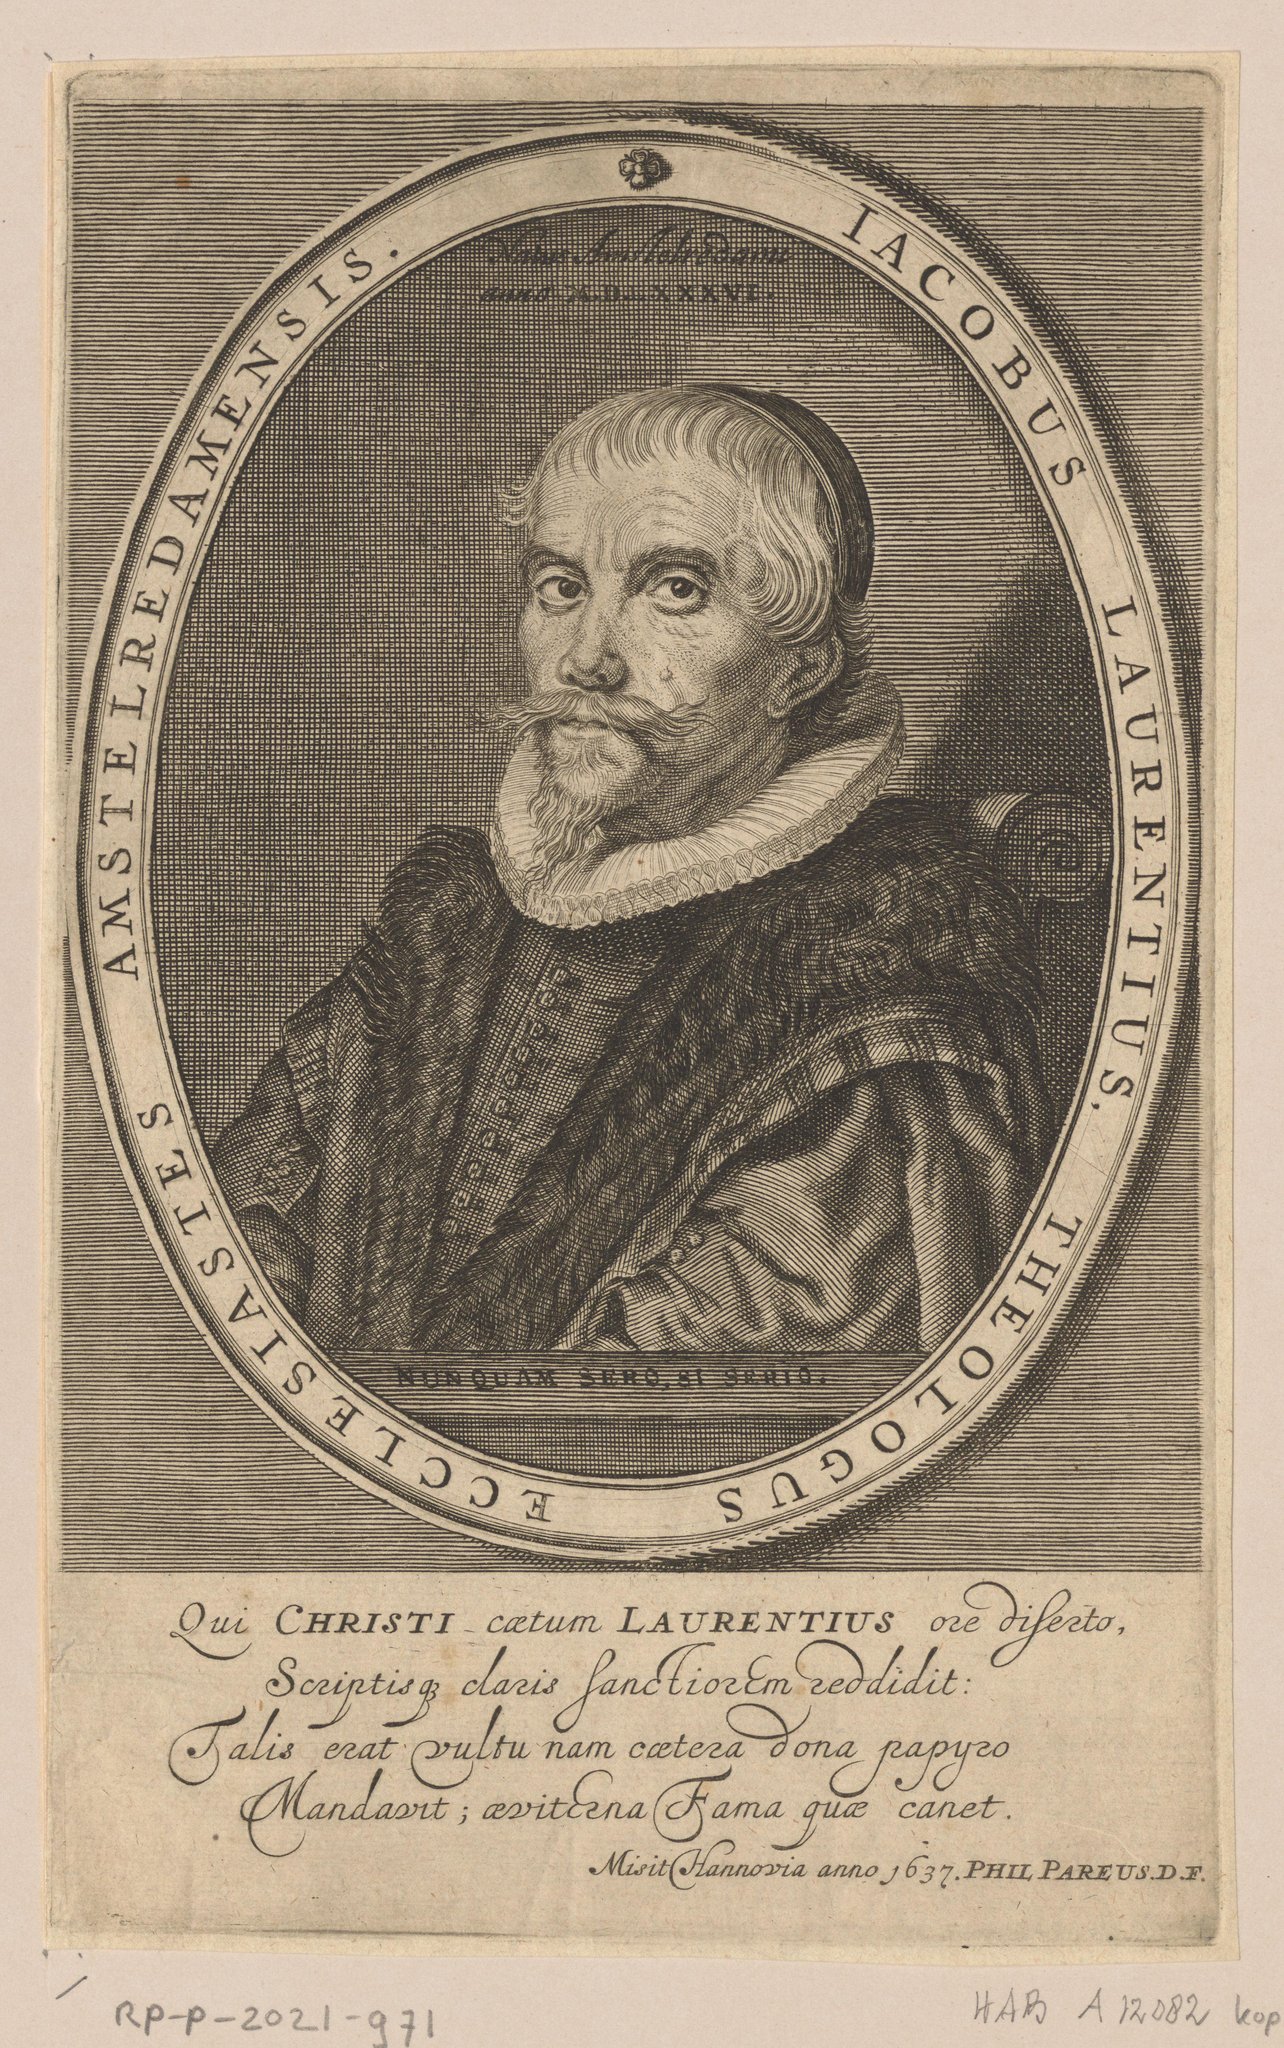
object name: print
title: Portret van Jacobus Laurentius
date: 1642-1692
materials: paper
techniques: engraving, etching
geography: northern netherlands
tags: amsterdam, historical persons, chair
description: Met vierregelig onderschrift in het Latijn en tekst in het Latijn rondom het portret.